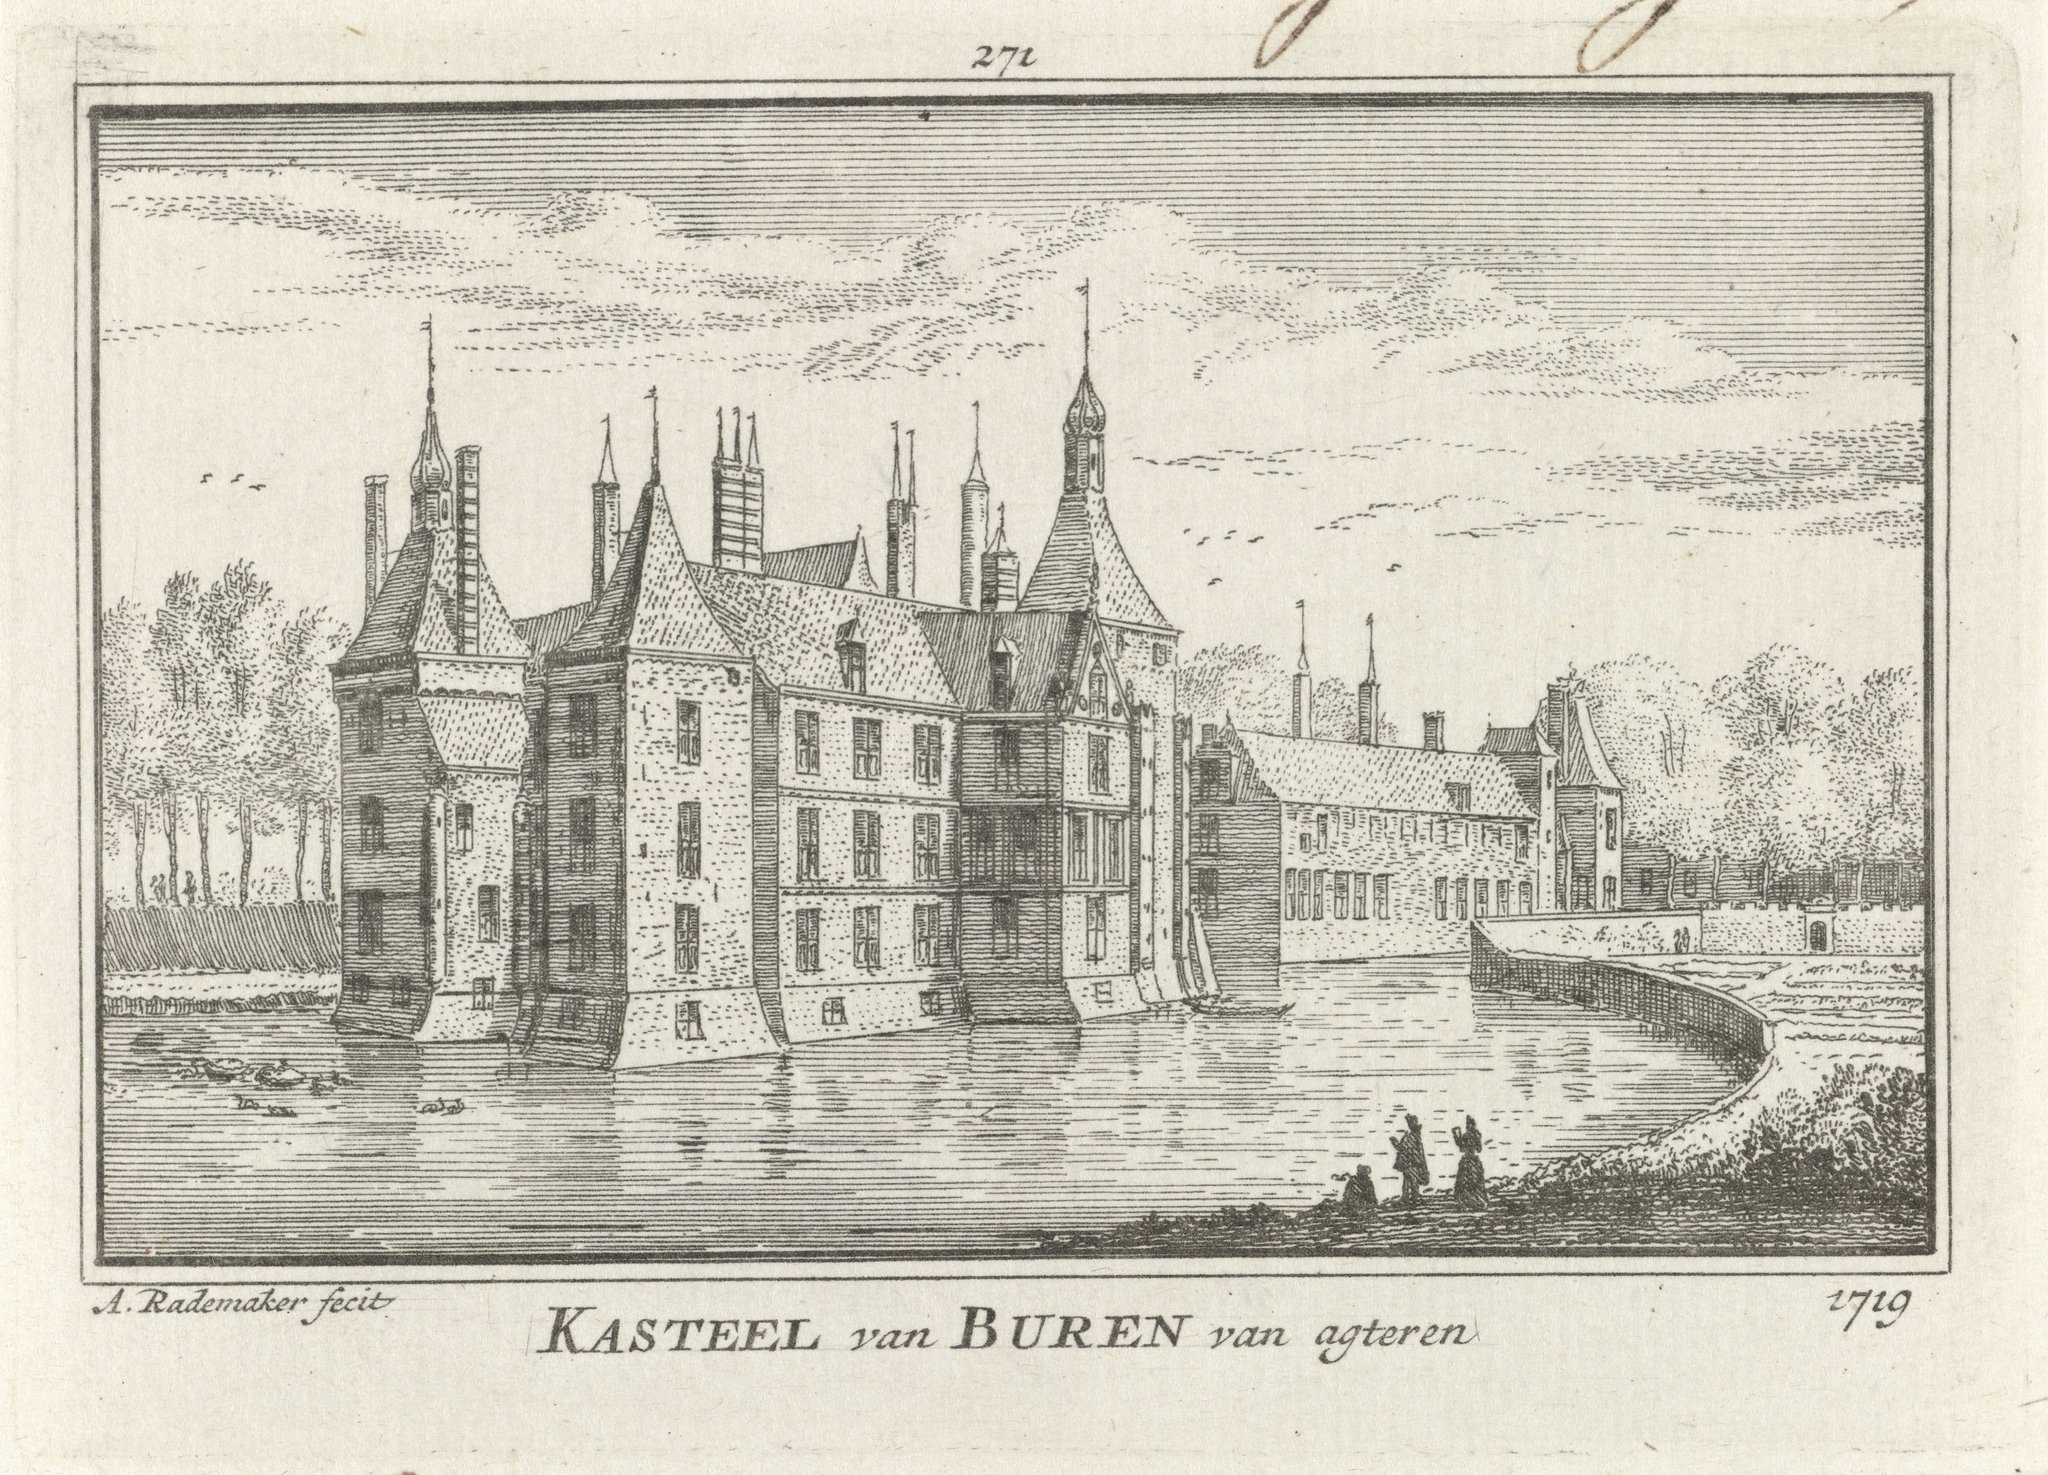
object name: print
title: Achterzijde van Kasteel Buren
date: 1727-1733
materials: paper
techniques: etching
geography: amsterdam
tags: kasteel buren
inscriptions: collector's mark: Lugt 2228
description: Illustratie uit: Abraham Rademaker, Matthaeus Brouërius van Niedek, Isaac Le Long, Kabinet van Nederlandsche en Kleefsche outheden en (...) voorname stads- en landgebouwen, Willem Barents en Antoni Schoonenburg: Amsterdam, 1727-1733, ill. nr. 271.